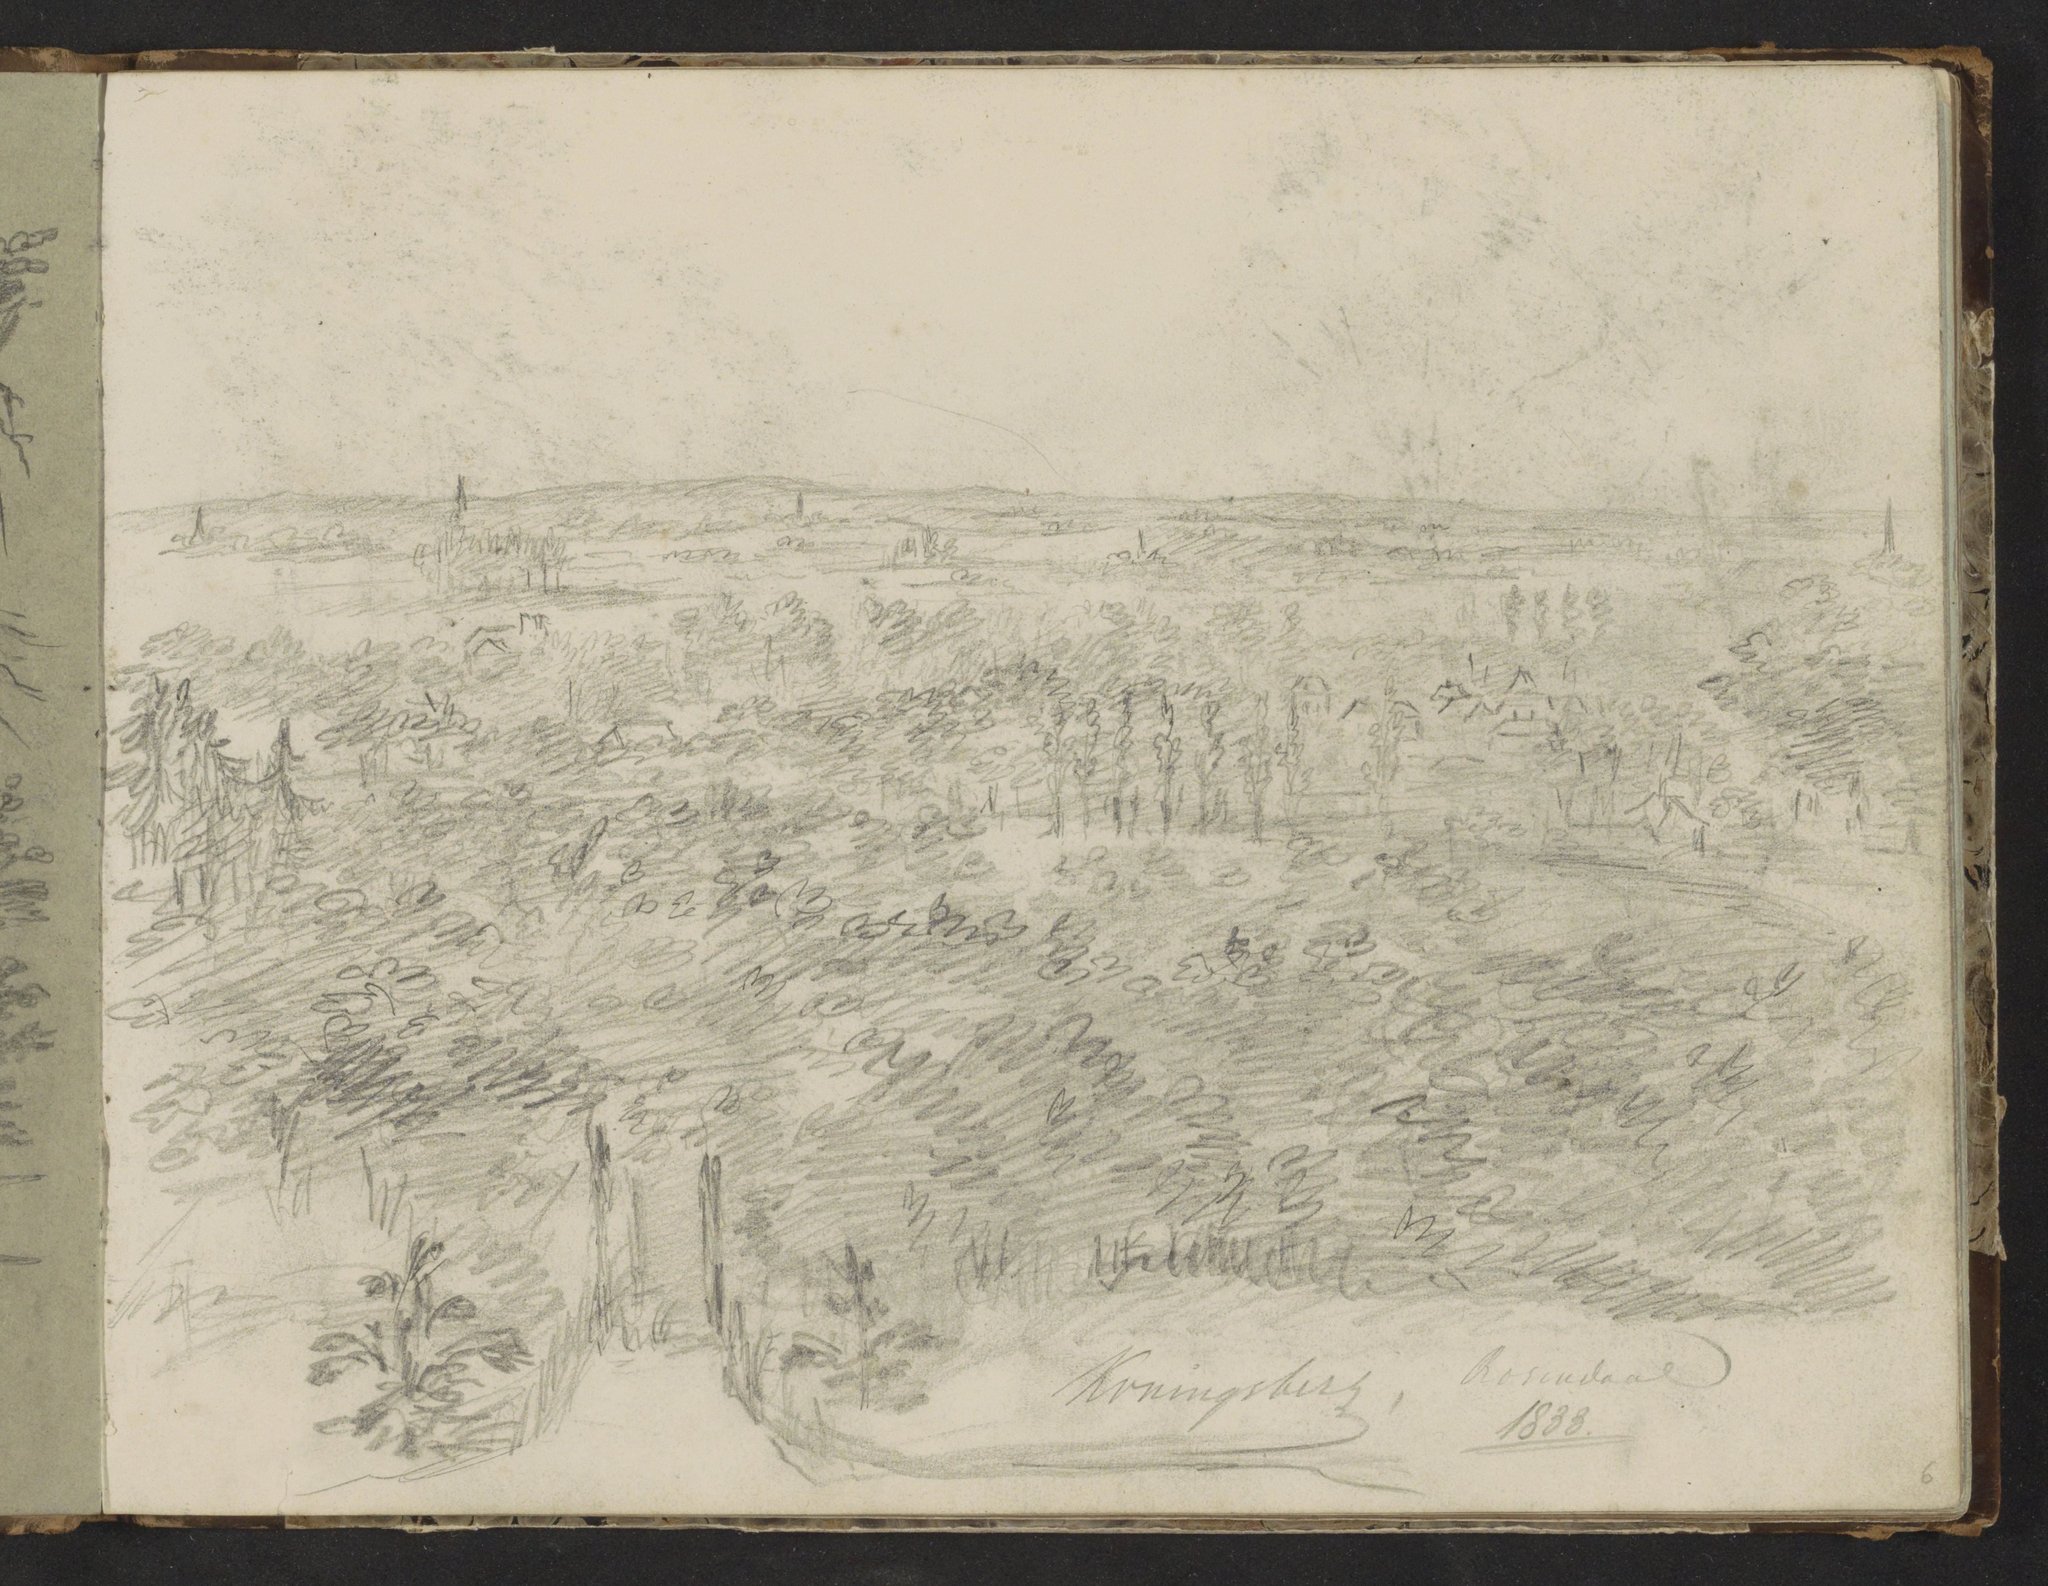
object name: sketchbook leaf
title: Koningsberg te Rozendaal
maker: johannes tavenraat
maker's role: draughtsman, painter, print maker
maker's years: 1809-1881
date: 1833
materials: paper, pencil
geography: rozendaal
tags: low hill country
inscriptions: date and inscription: ‘Koningsberg, Rosendaal/ 1833’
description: Blad 6 recto uit een schetsboek met 41 bladen.